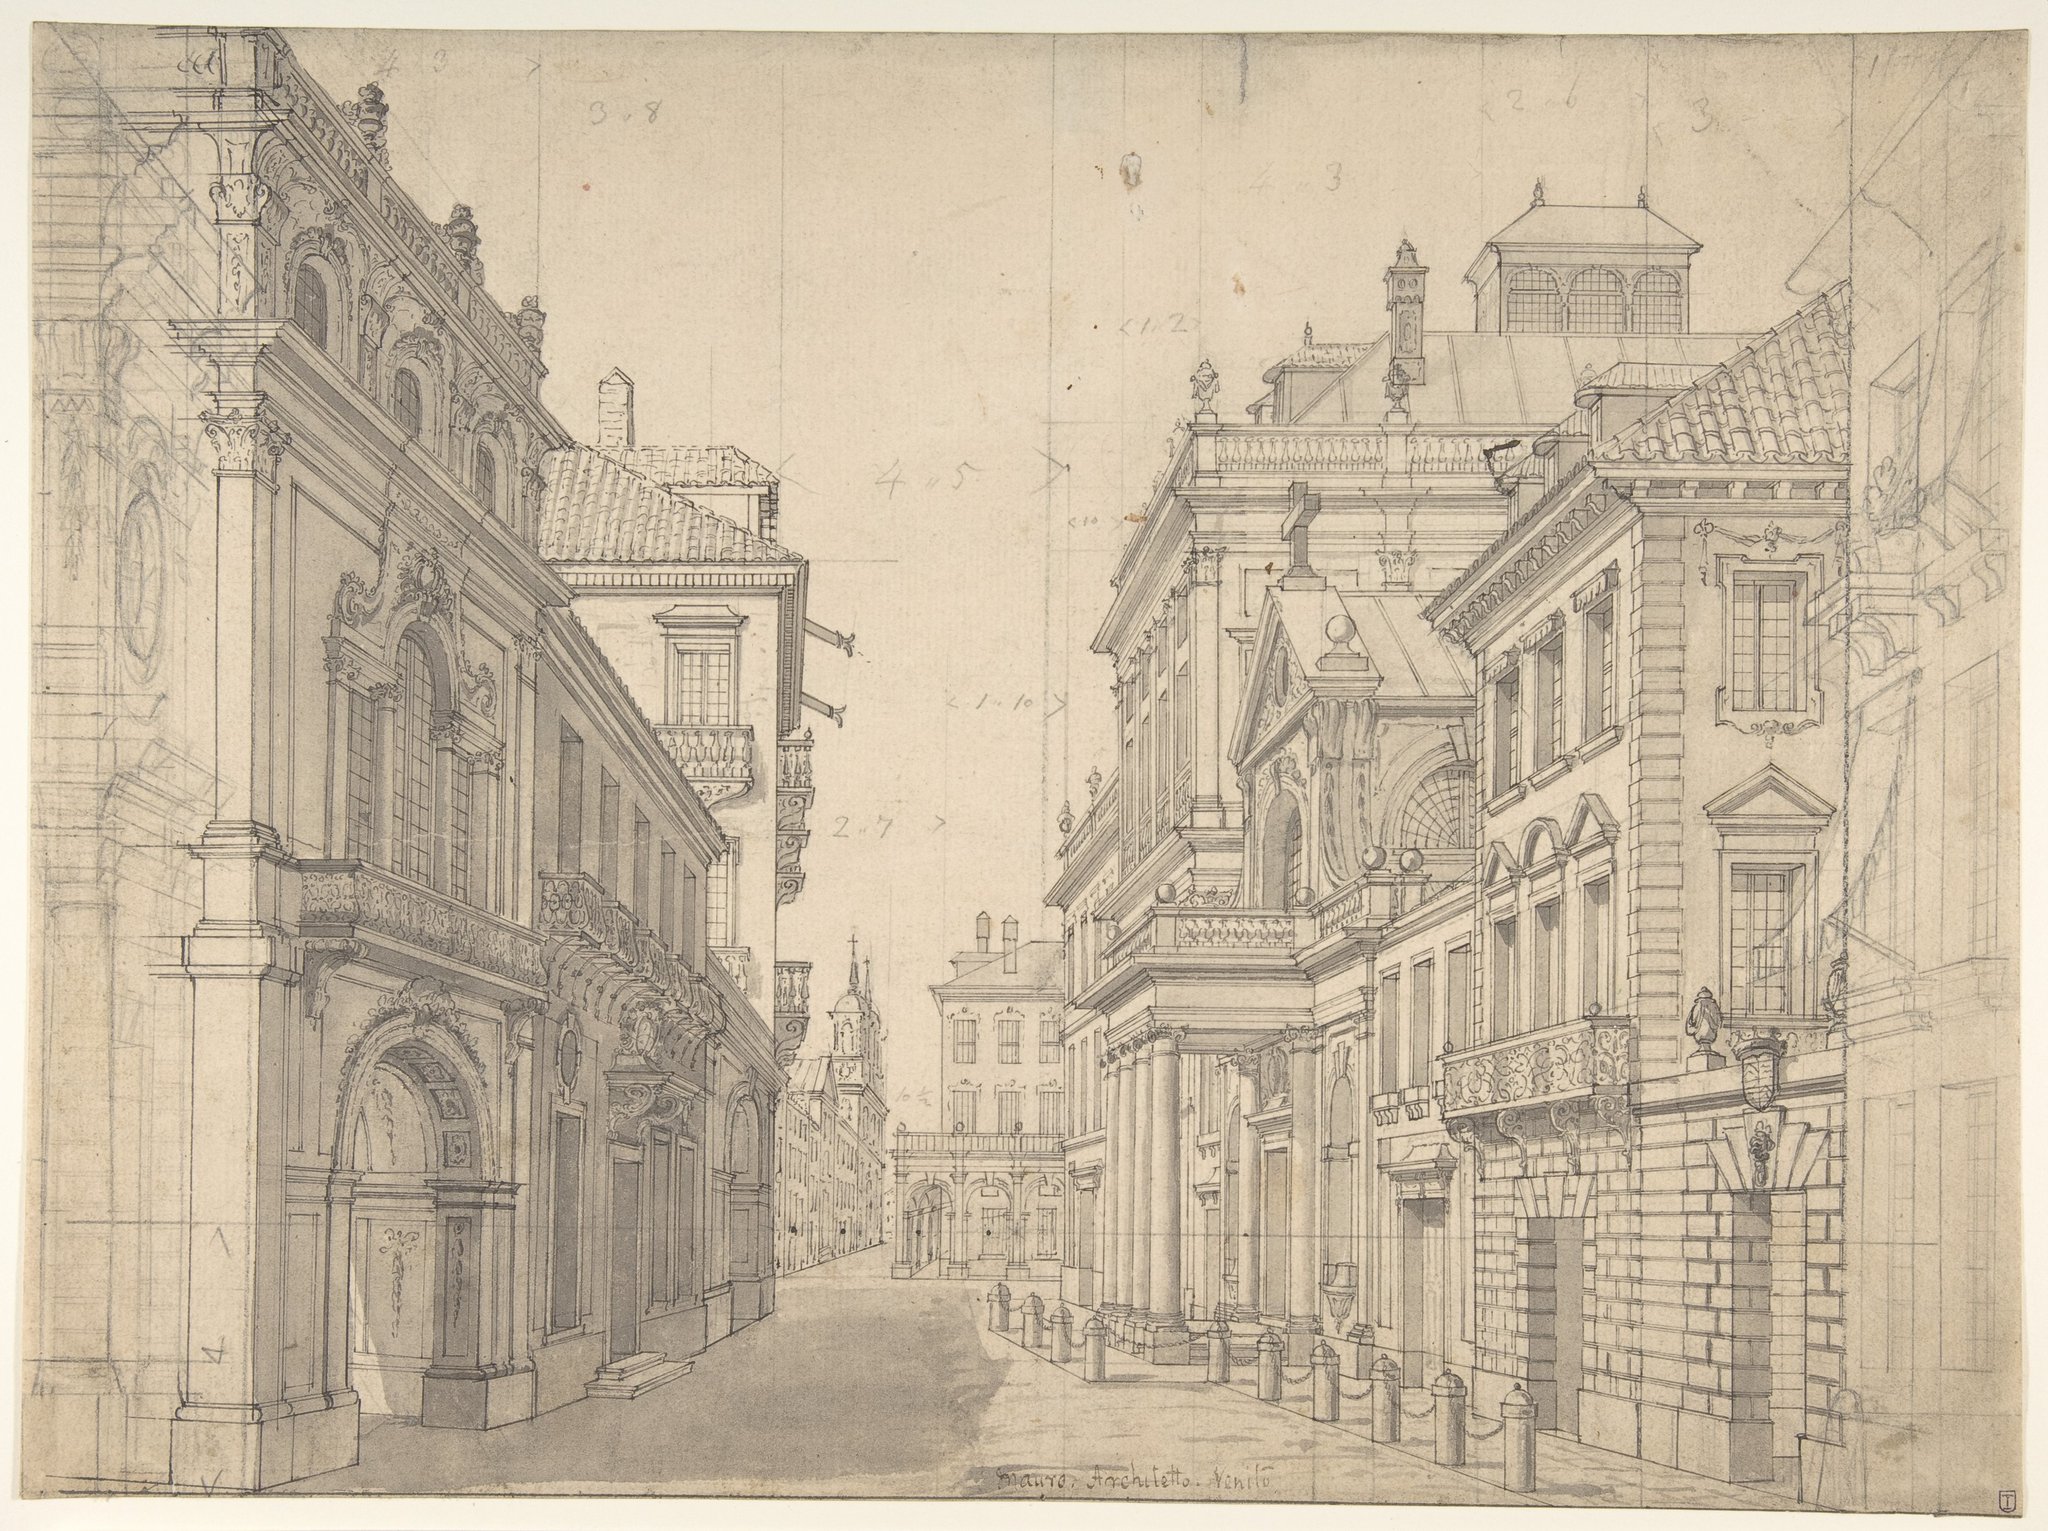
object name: drawing ornament architecture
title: Perspective Design for a Stage Set of an Italian Cityscape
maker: antonio mauro ii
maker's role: artist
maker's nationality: italian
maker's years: 1784-1797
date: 1784-1797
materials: ink, drawing material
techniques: pen, wash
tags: buildings,roads,stage design